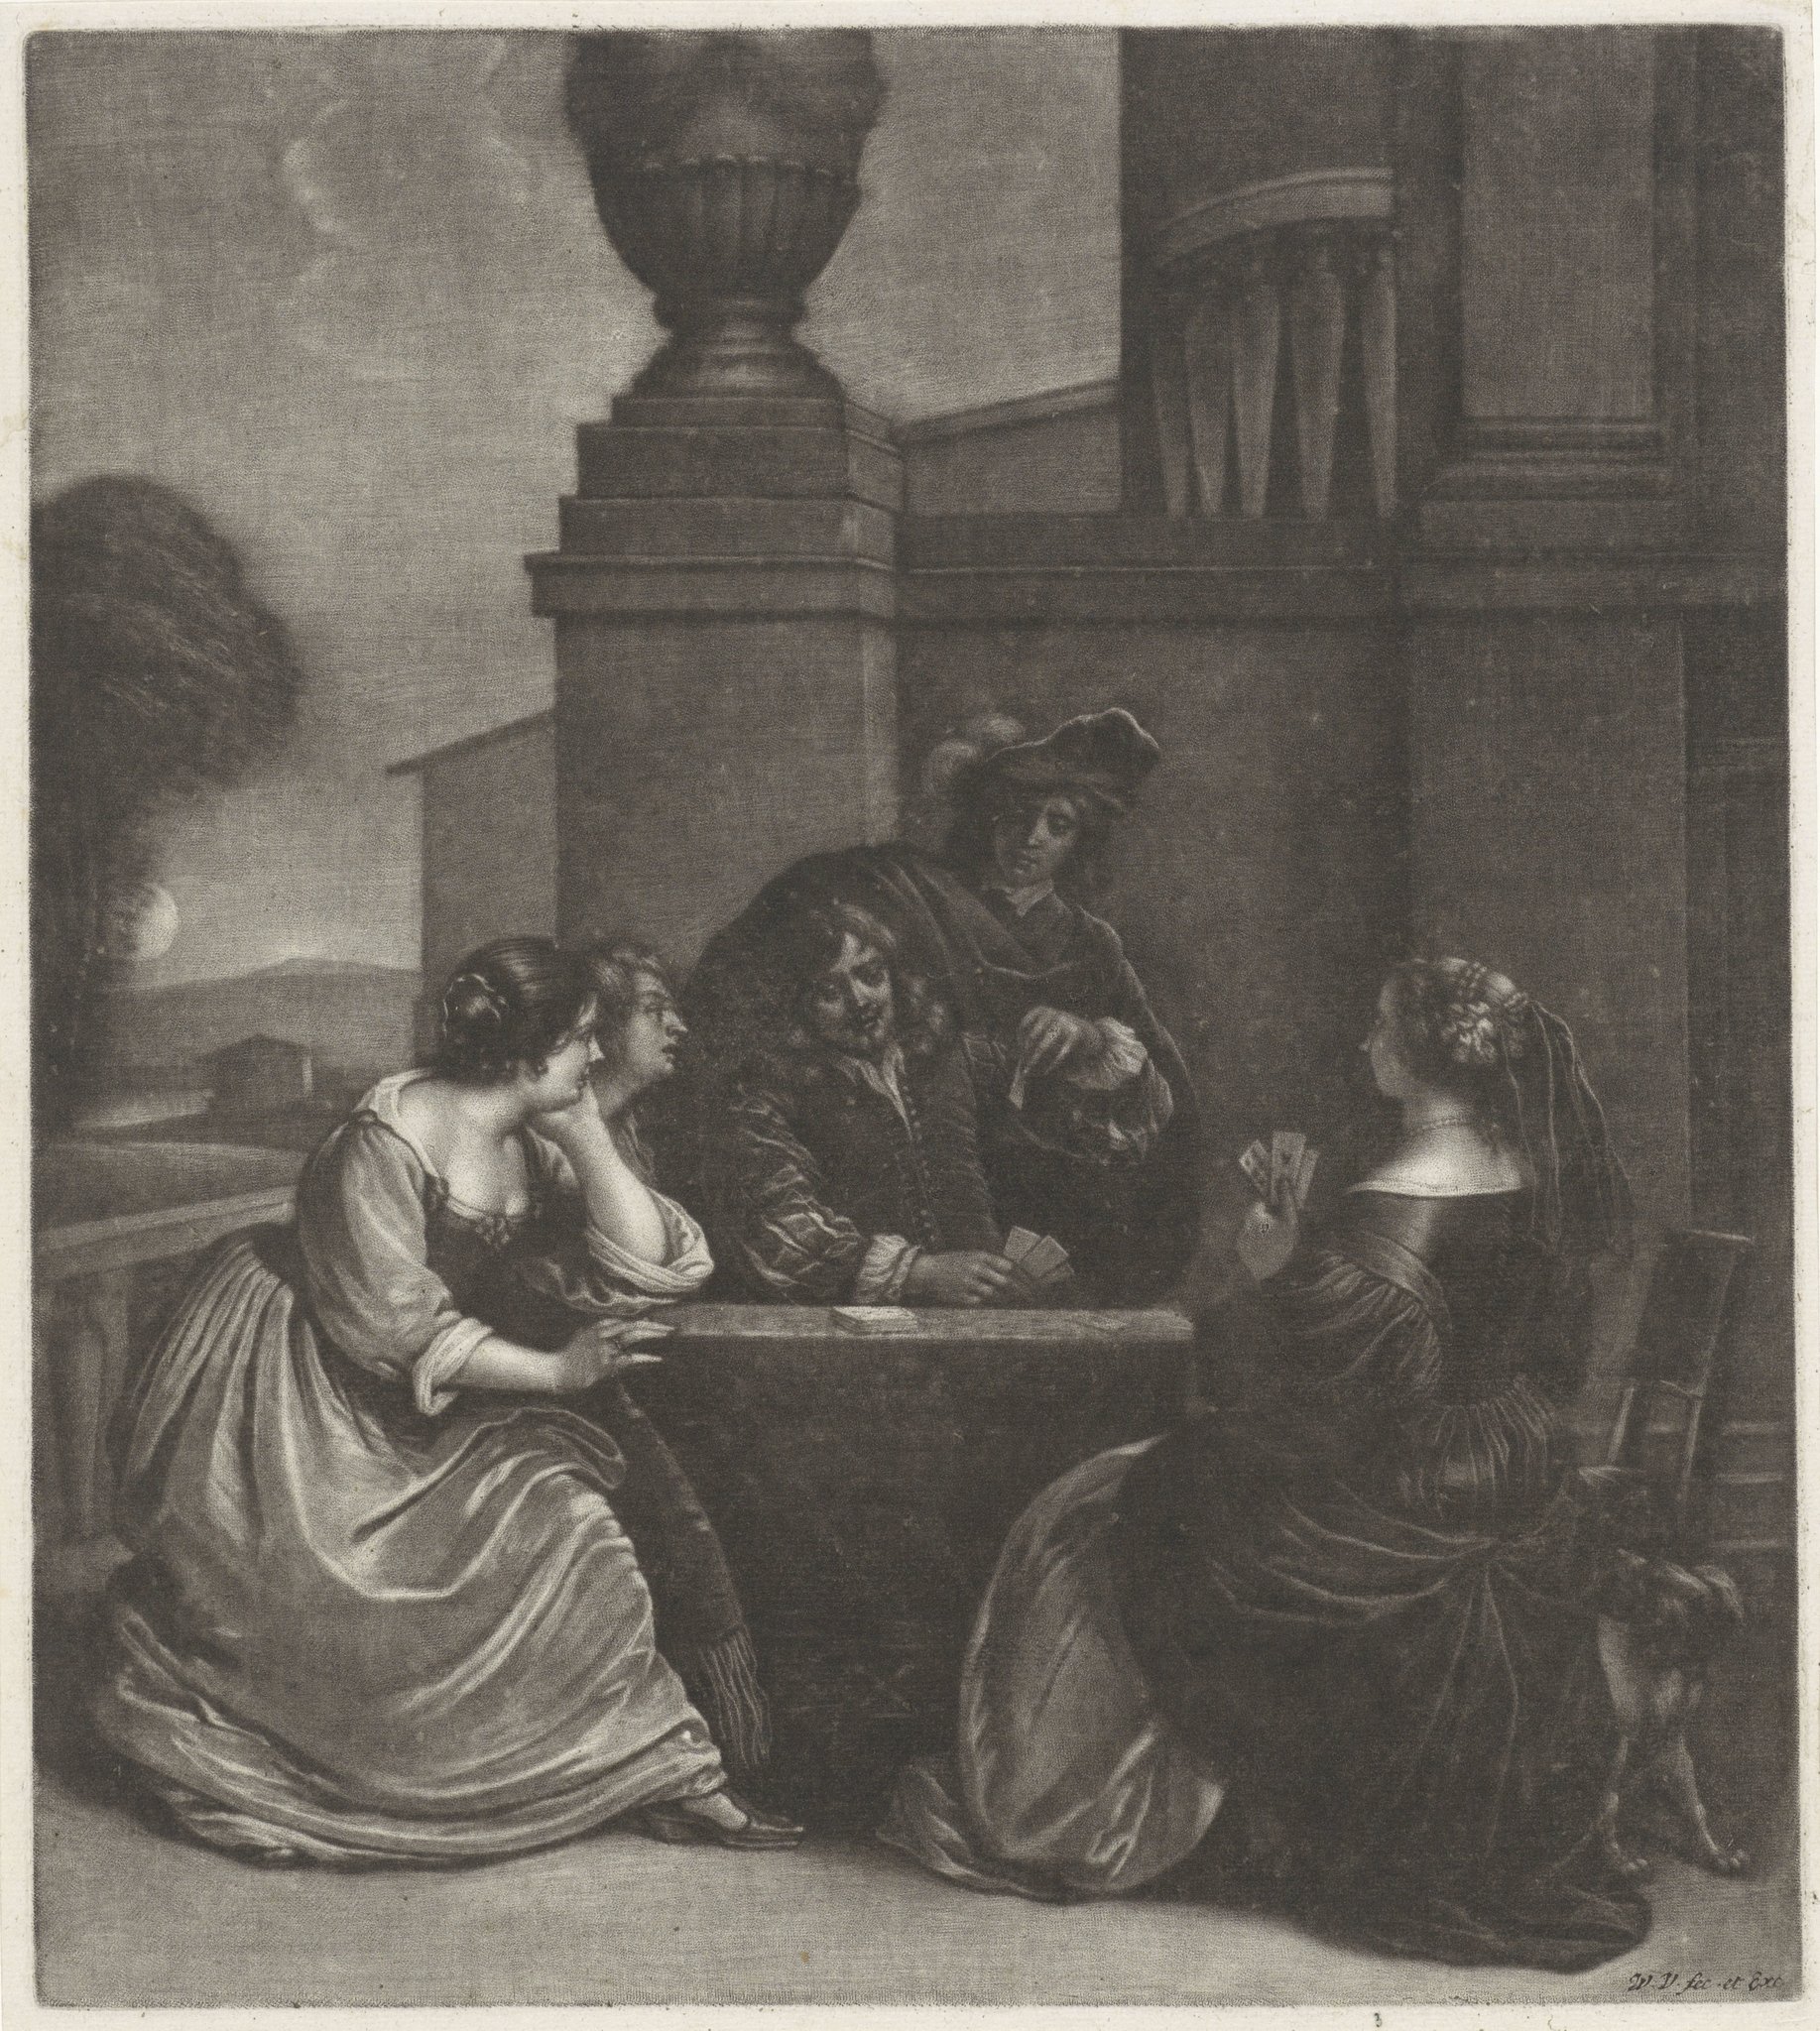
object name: print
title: Kaartspelend gezelschap op een terras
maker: wallerant vaillant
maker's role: draughtsman, painter, print maker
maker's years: 1623-1677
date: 1658-1677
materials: paper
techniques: mezzotint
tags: playing-cards, dog, private festivities, merry company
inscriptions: collector's mark: Lugt 10, collector's mark: Lugt 11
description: Op een terras zit een elegant gezelschap van mannen en vrouwen kaart te spelen.